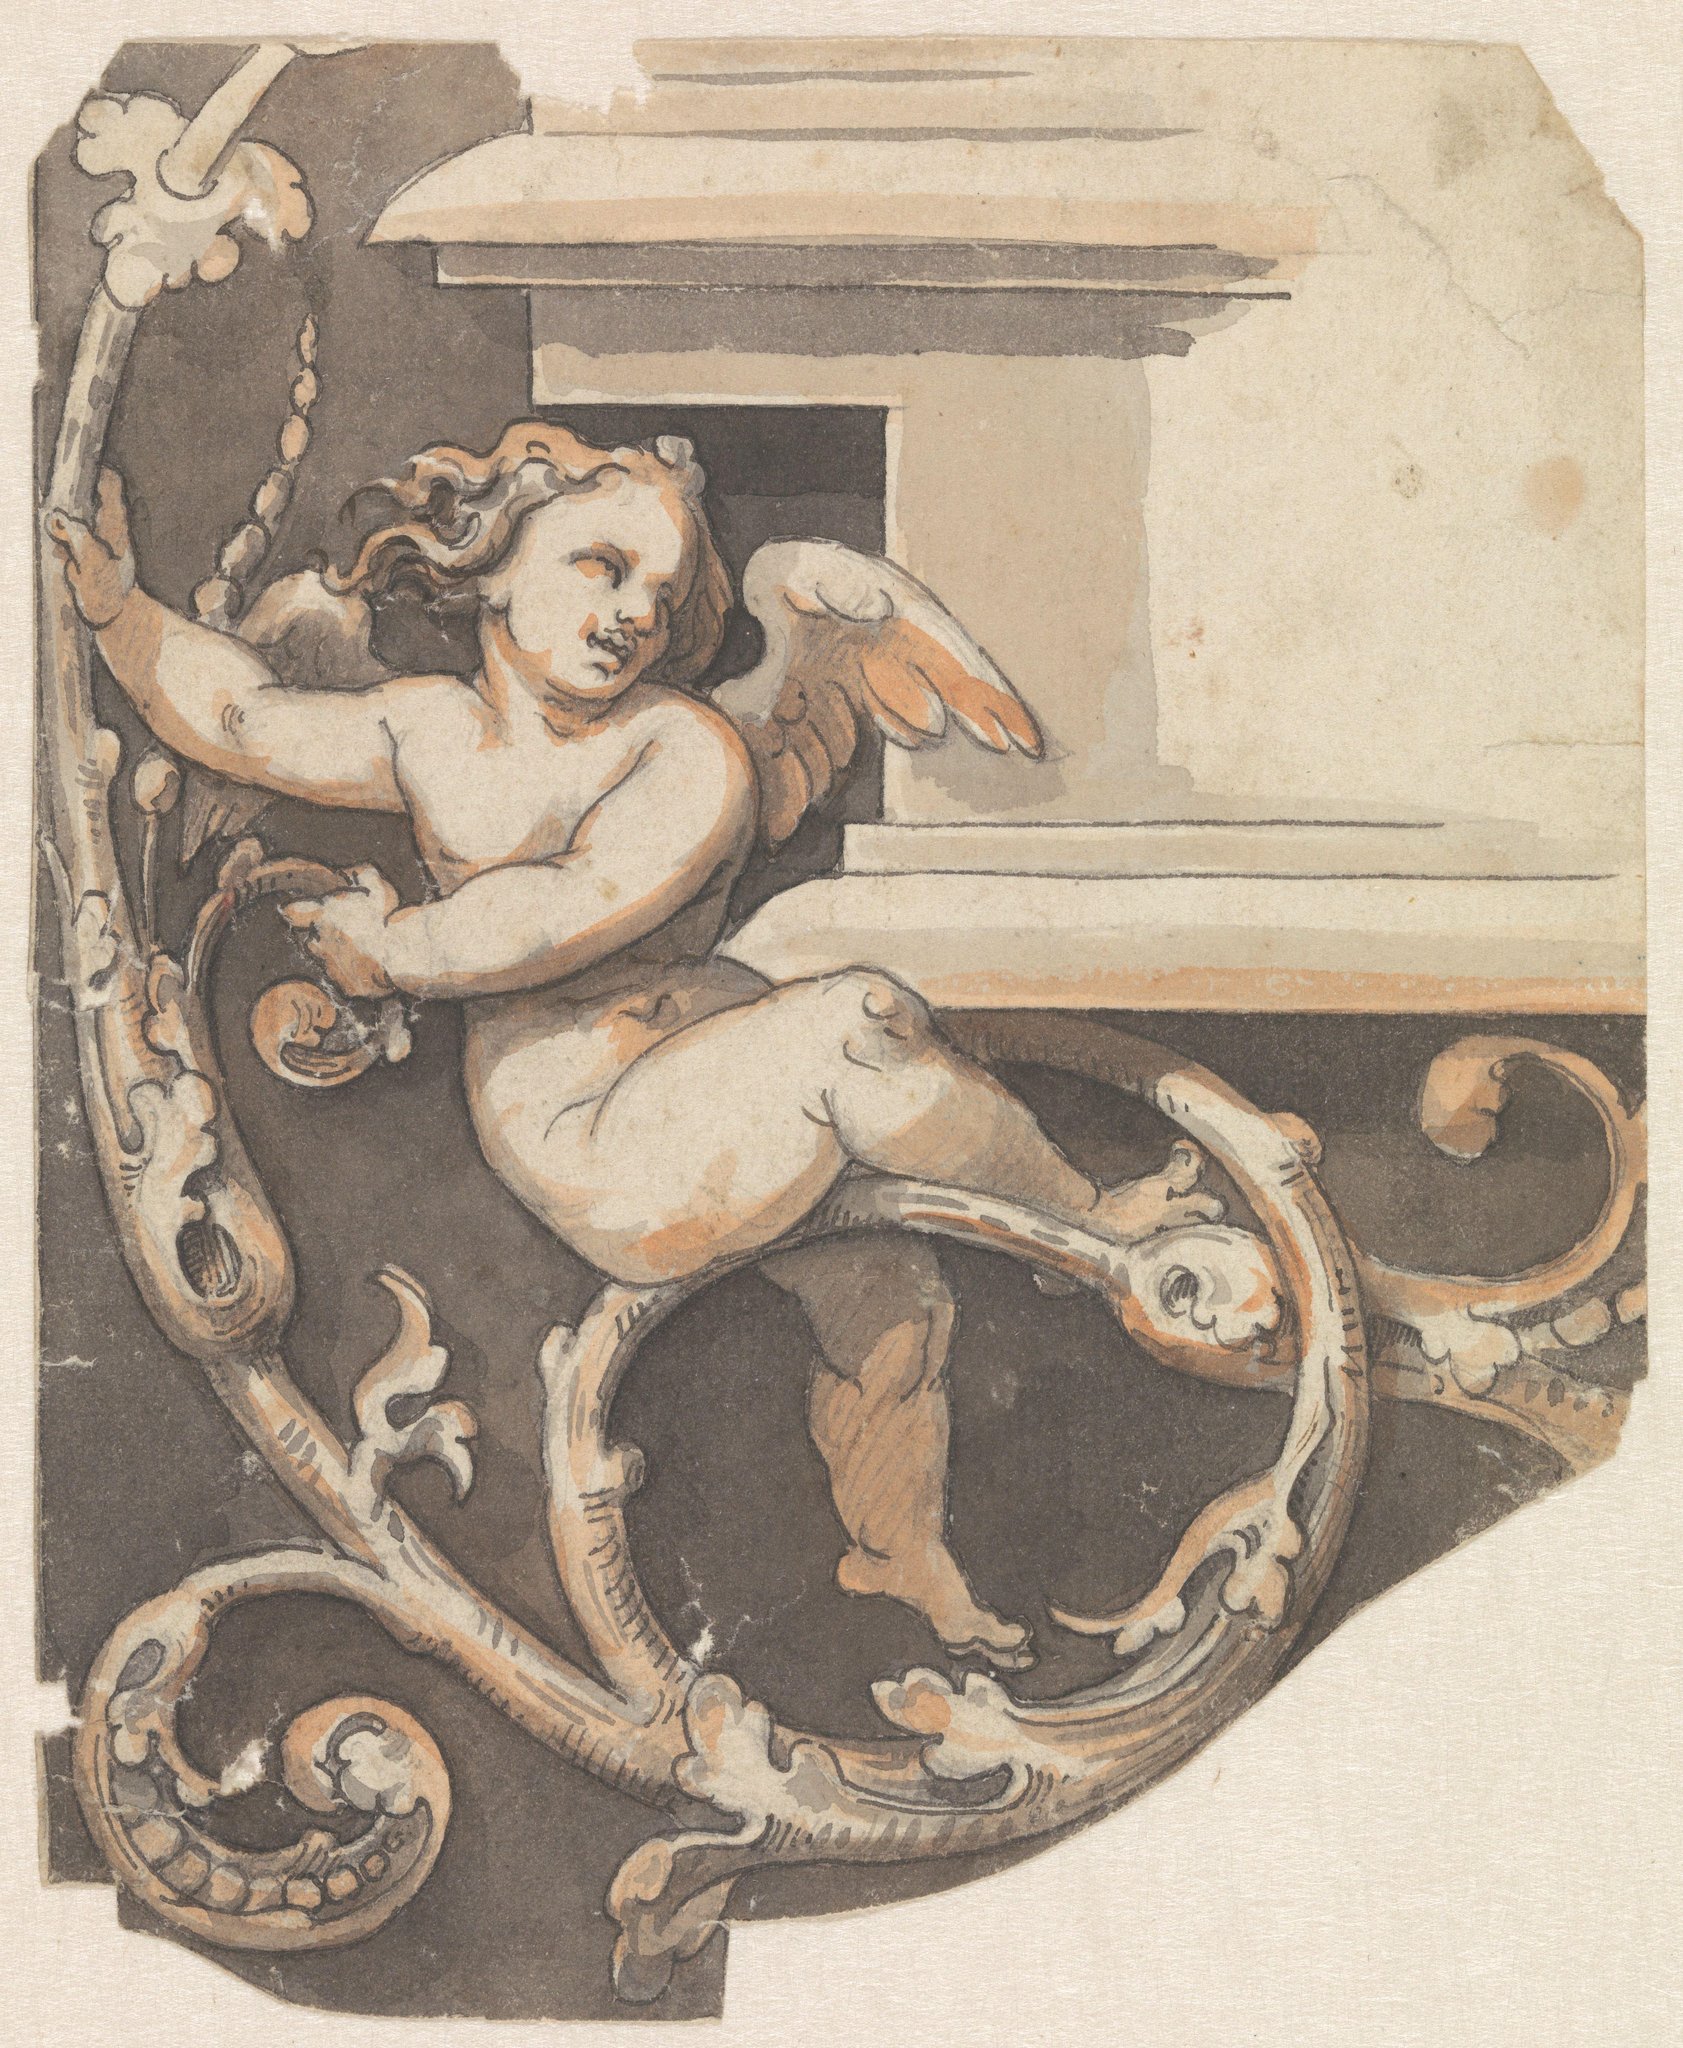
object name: design drawing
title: Putto gezeten op een bladrank voor de hoek van een geprofileerde kroonlijst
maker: Anonymous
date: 1840-1860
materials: graphite, paper, watercolor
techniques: aquarelle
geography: france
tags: cupids: 'amores', 'amoretti', 'putti', ornament derived from plant forms